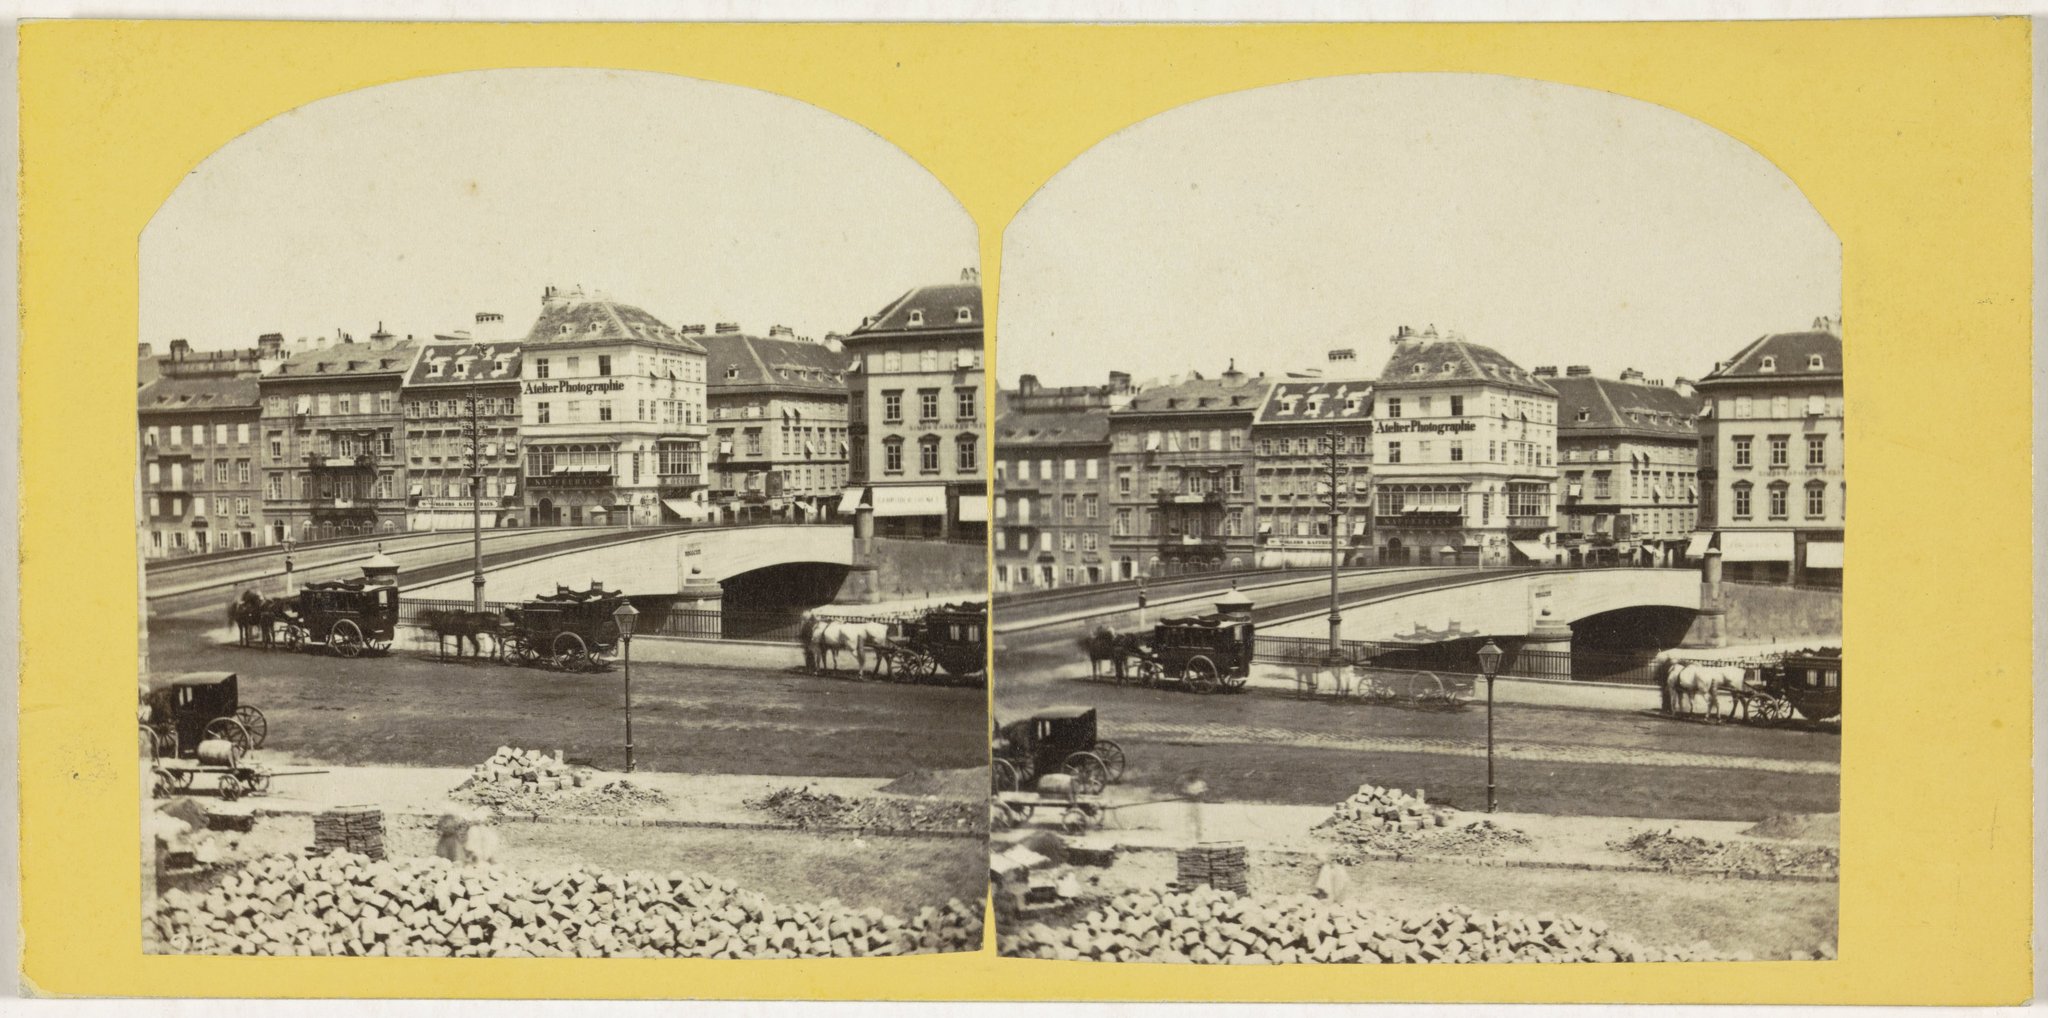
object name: stereograph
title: Ferdinandsbrücke in Wenen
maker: Anonymous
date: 1865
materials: cardboard, paper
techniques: albumen print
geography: vienna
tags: bridge in city across river, canal, etc.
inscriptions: inscription: ‘Dec 1865’, number: ‘III’, number: ‘177’